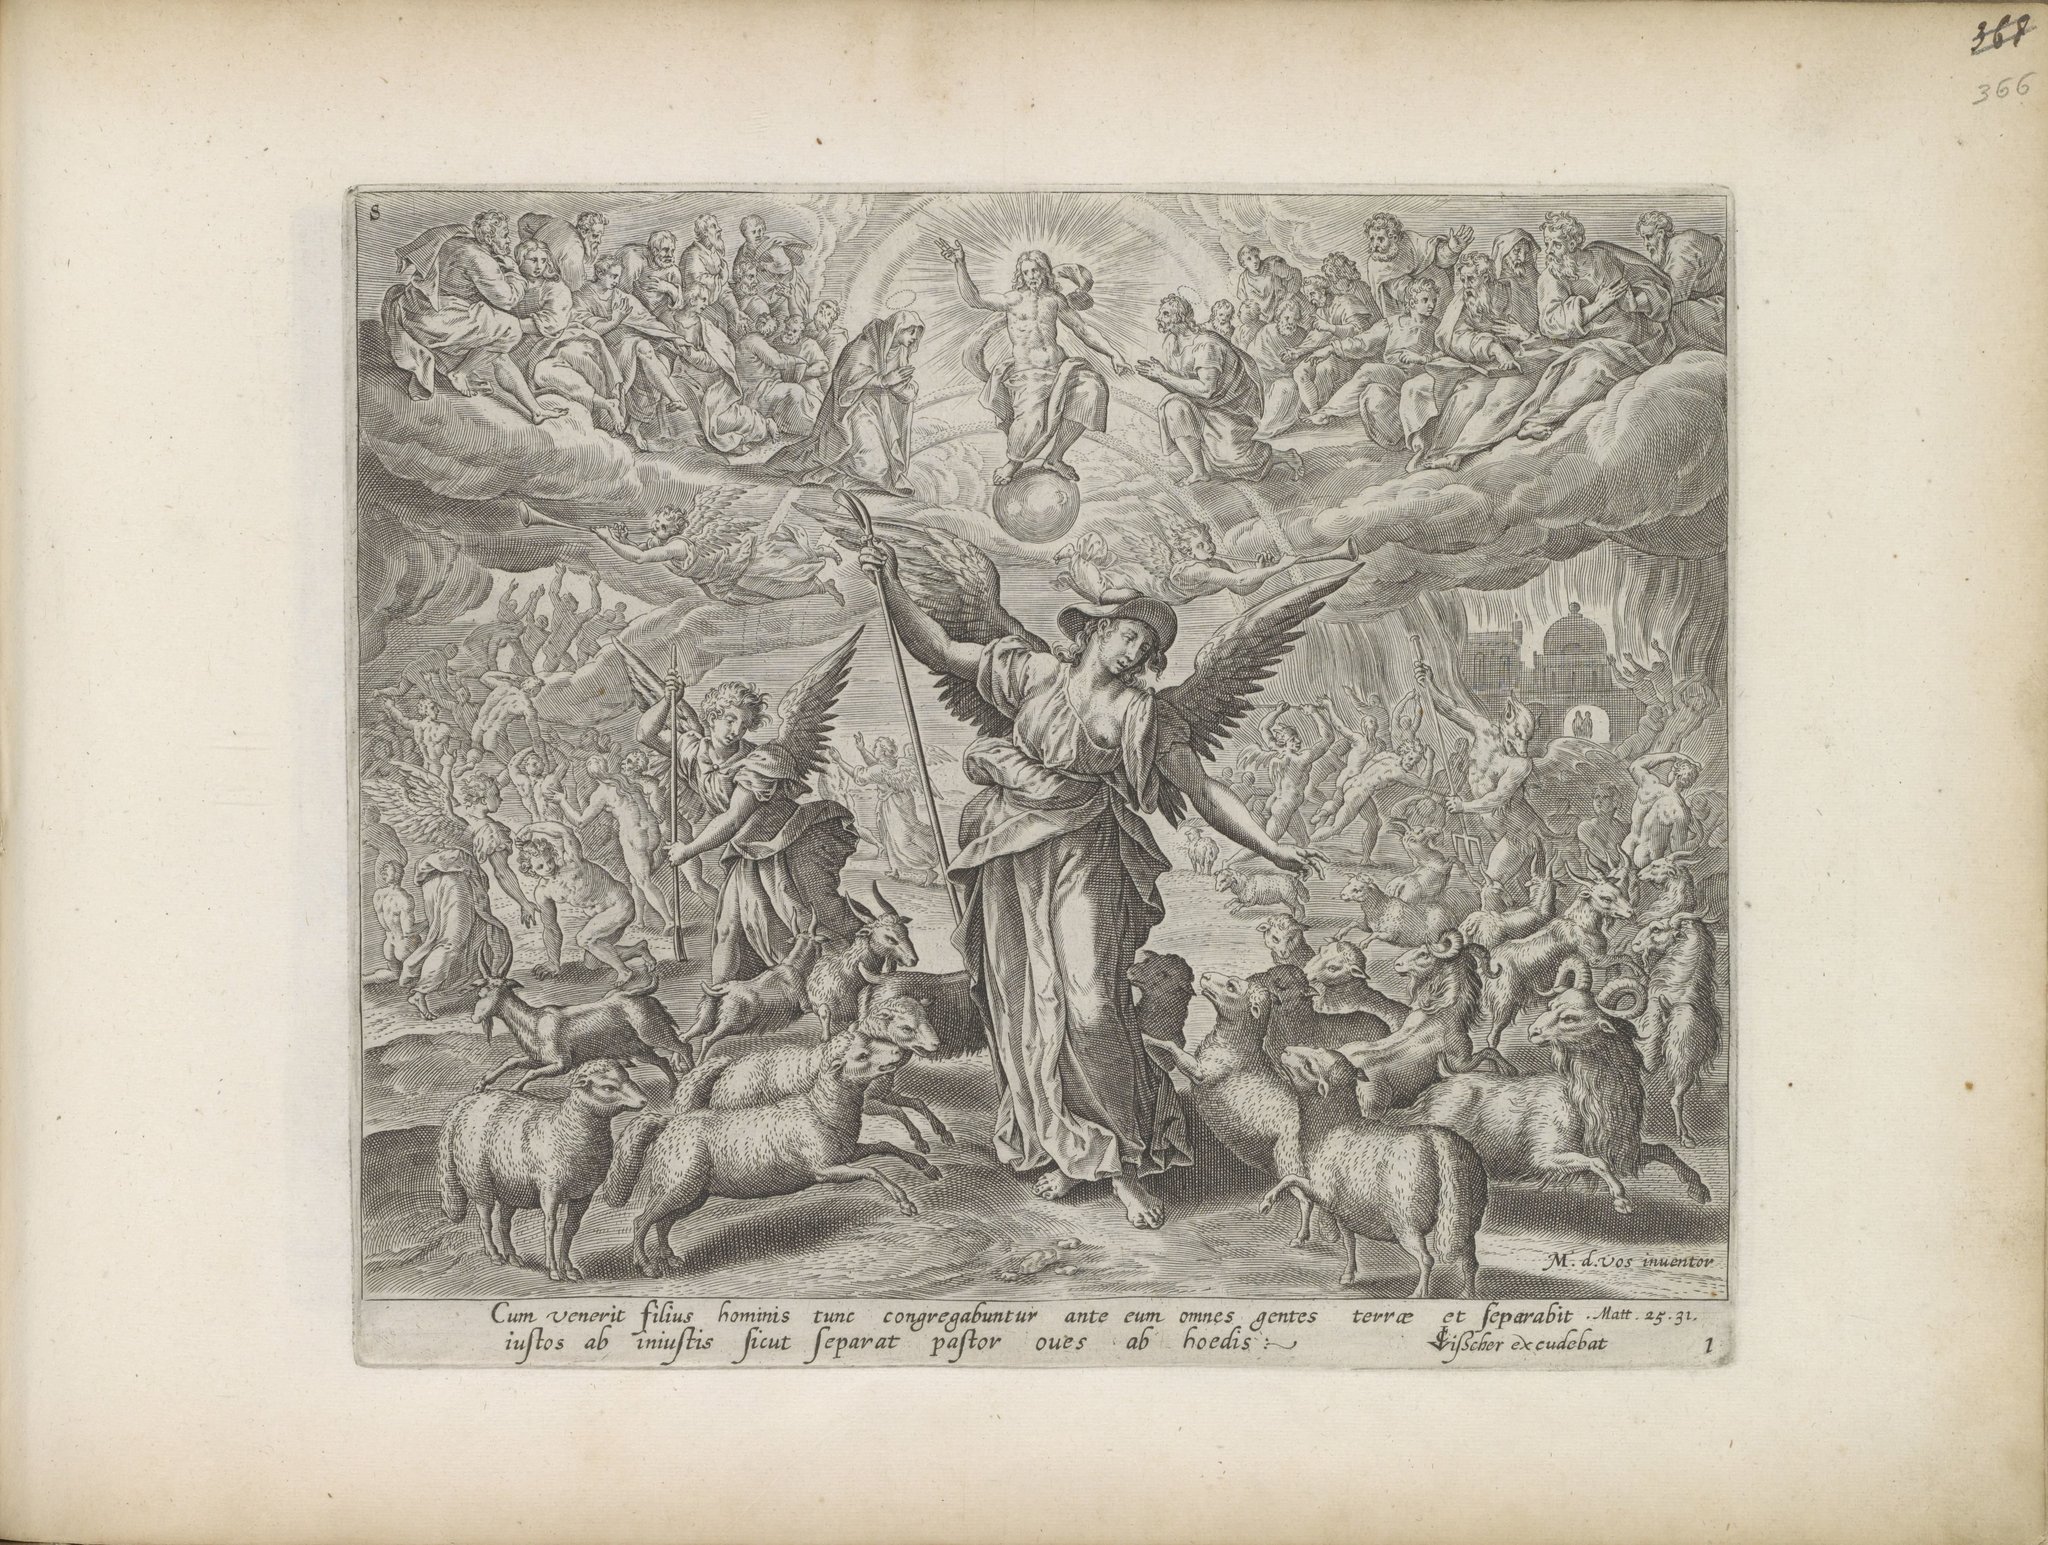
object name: print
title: Scheiden van de schapen en de bokken en het laatste oordeel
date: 1585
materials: paper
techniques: engraving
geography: amsterdam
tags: 'as a shepherd (the son of man) separates the sheep from the goats' (matthew 25:32), representation of last judgement, with the archangel michael weighing the souls (or dividing the blessed and the damned)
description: De aartsengel Michael scheidt de schapen van de bokken. Christus troont op de wolken, geflankeerd door Maria en Johannes. De doden worden door engelen naar de hemel geleid (links) of naar de hel gevoerd (rechts). Onder de voorstelling een verwijzing in het Latijn naar de Bijbeltekst in Mat. 25:31. Deze prent maakt deel uit van een album.